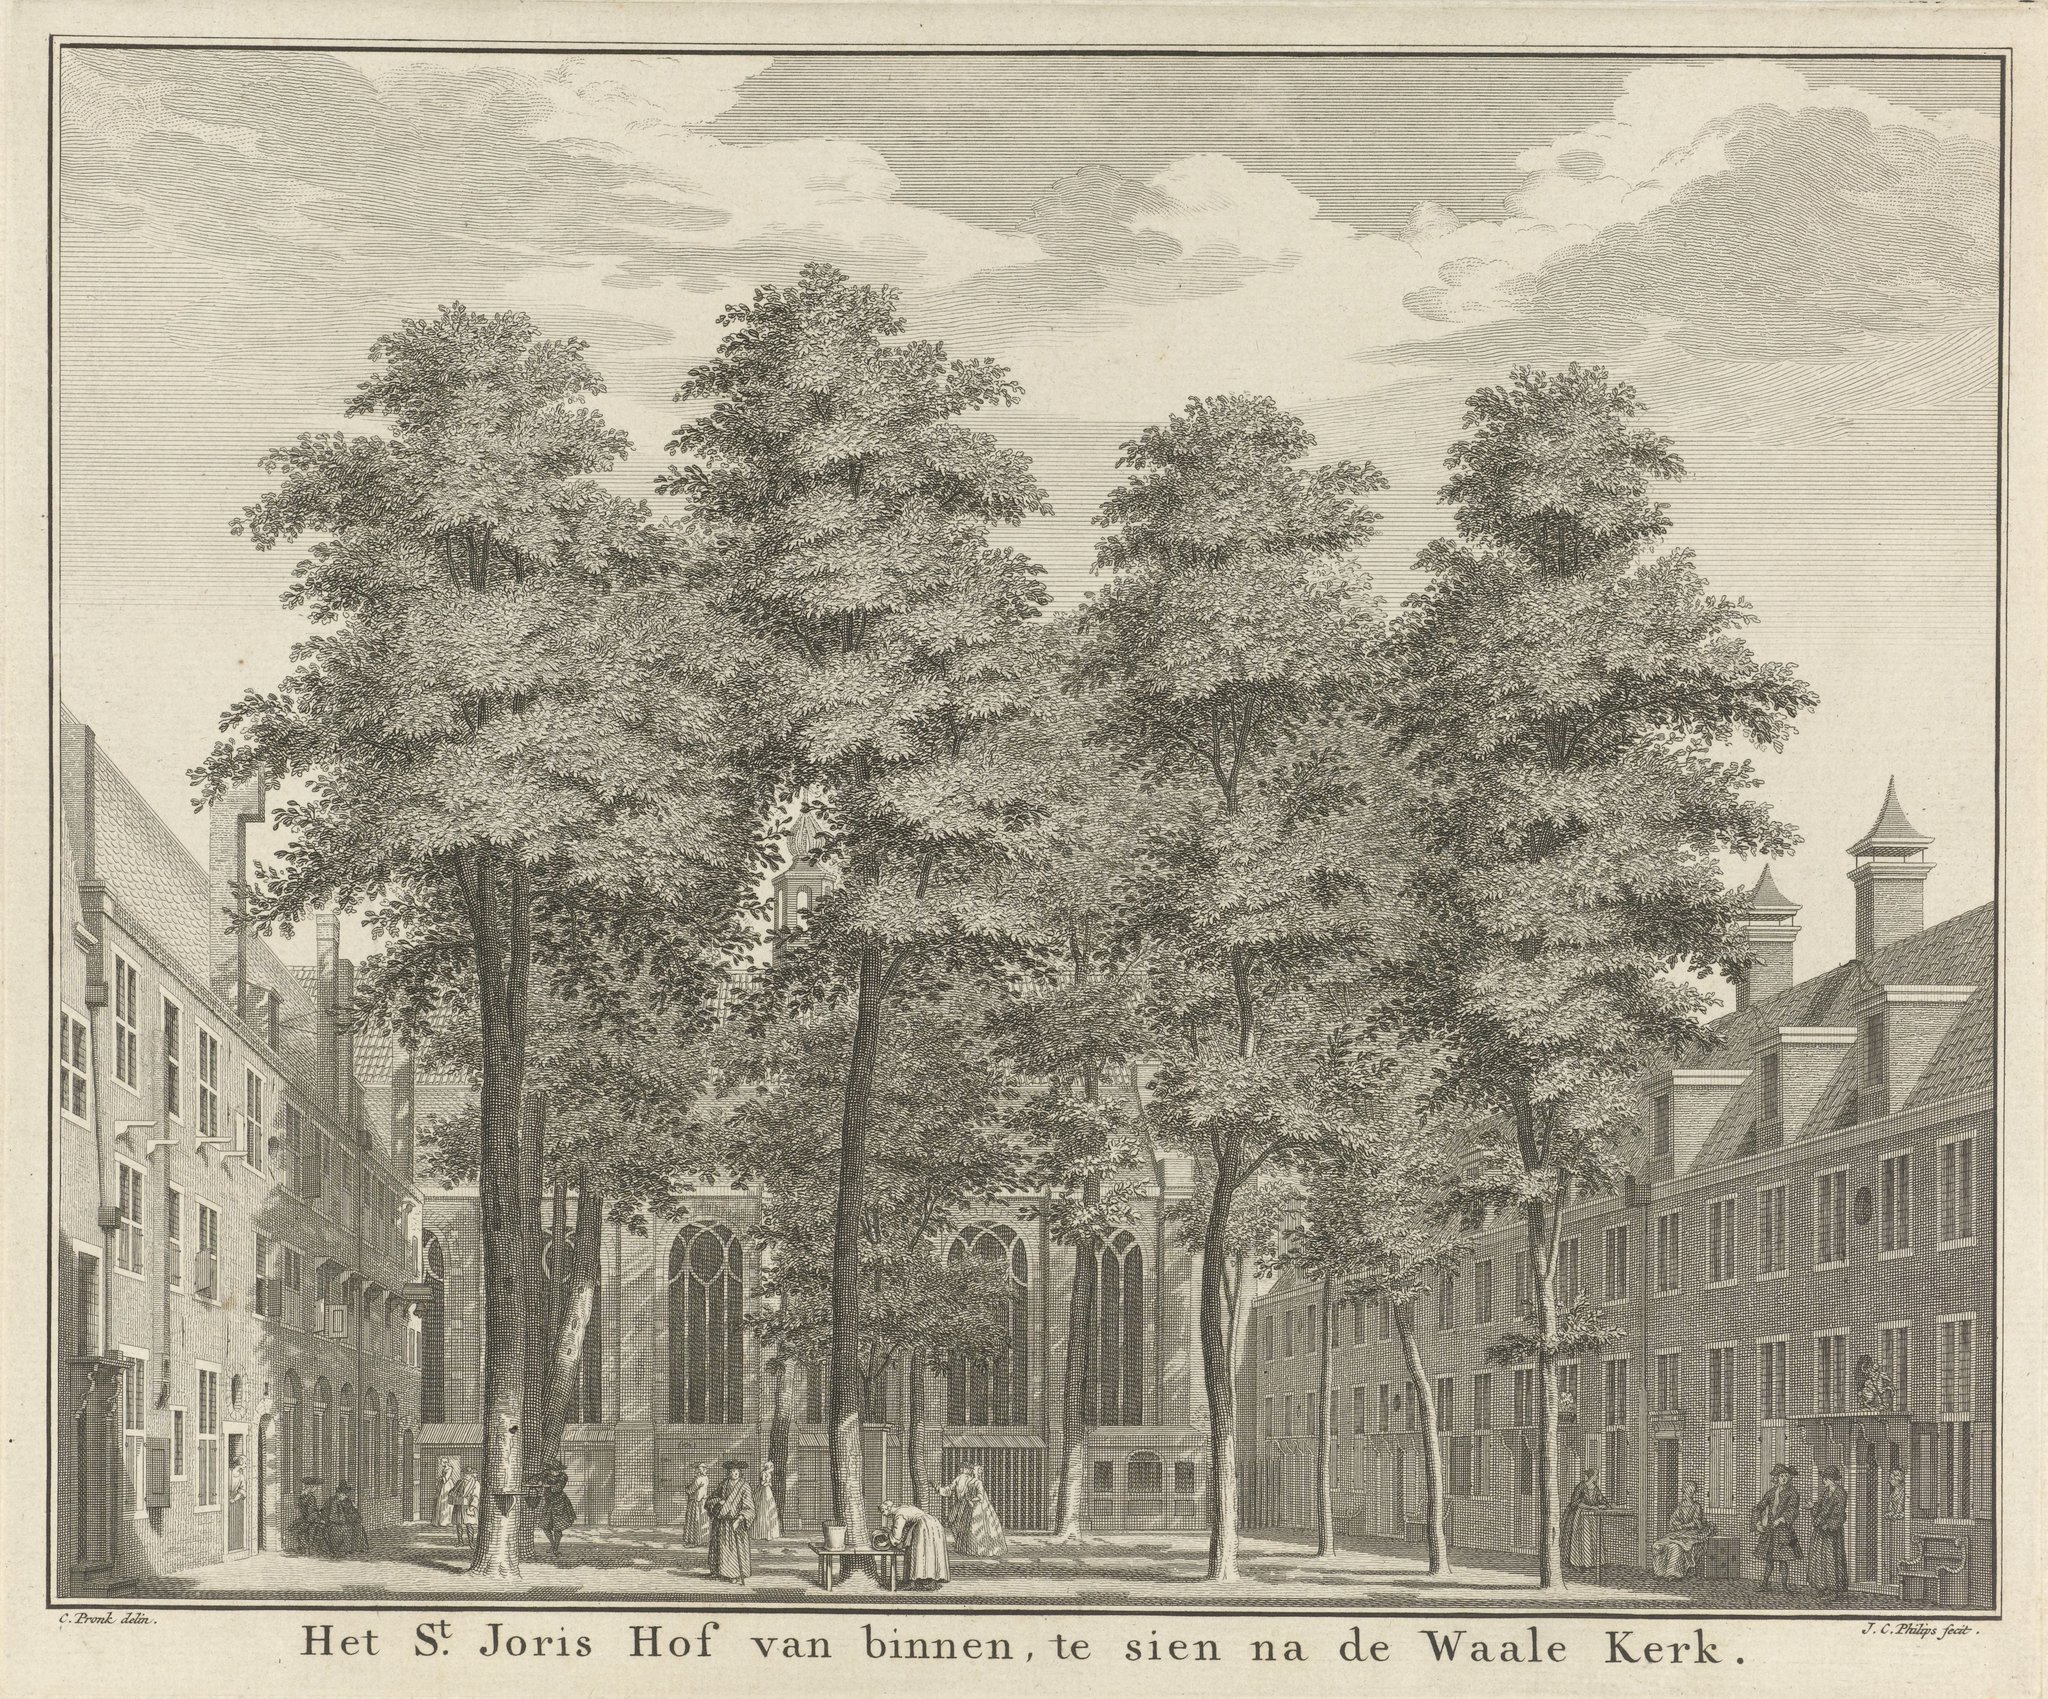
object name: print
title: Gezicht op de Waalse Kerk en het Sint-Jorishof te Amsterdam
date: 1736-1759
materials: paper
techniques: engraving, etching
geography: amsterdam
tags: alms-house (dutch: 'hofje'), church (exterior), courtyard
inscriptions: collector's mark: Lugt 2228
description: Gezicht op de Waalse Kerk (op de achtergrond) en het Sint-Jorishof te Amsterdam. Op de met bomen beplante binnenplaats en voor de proveniershuizen verschillende figuren.